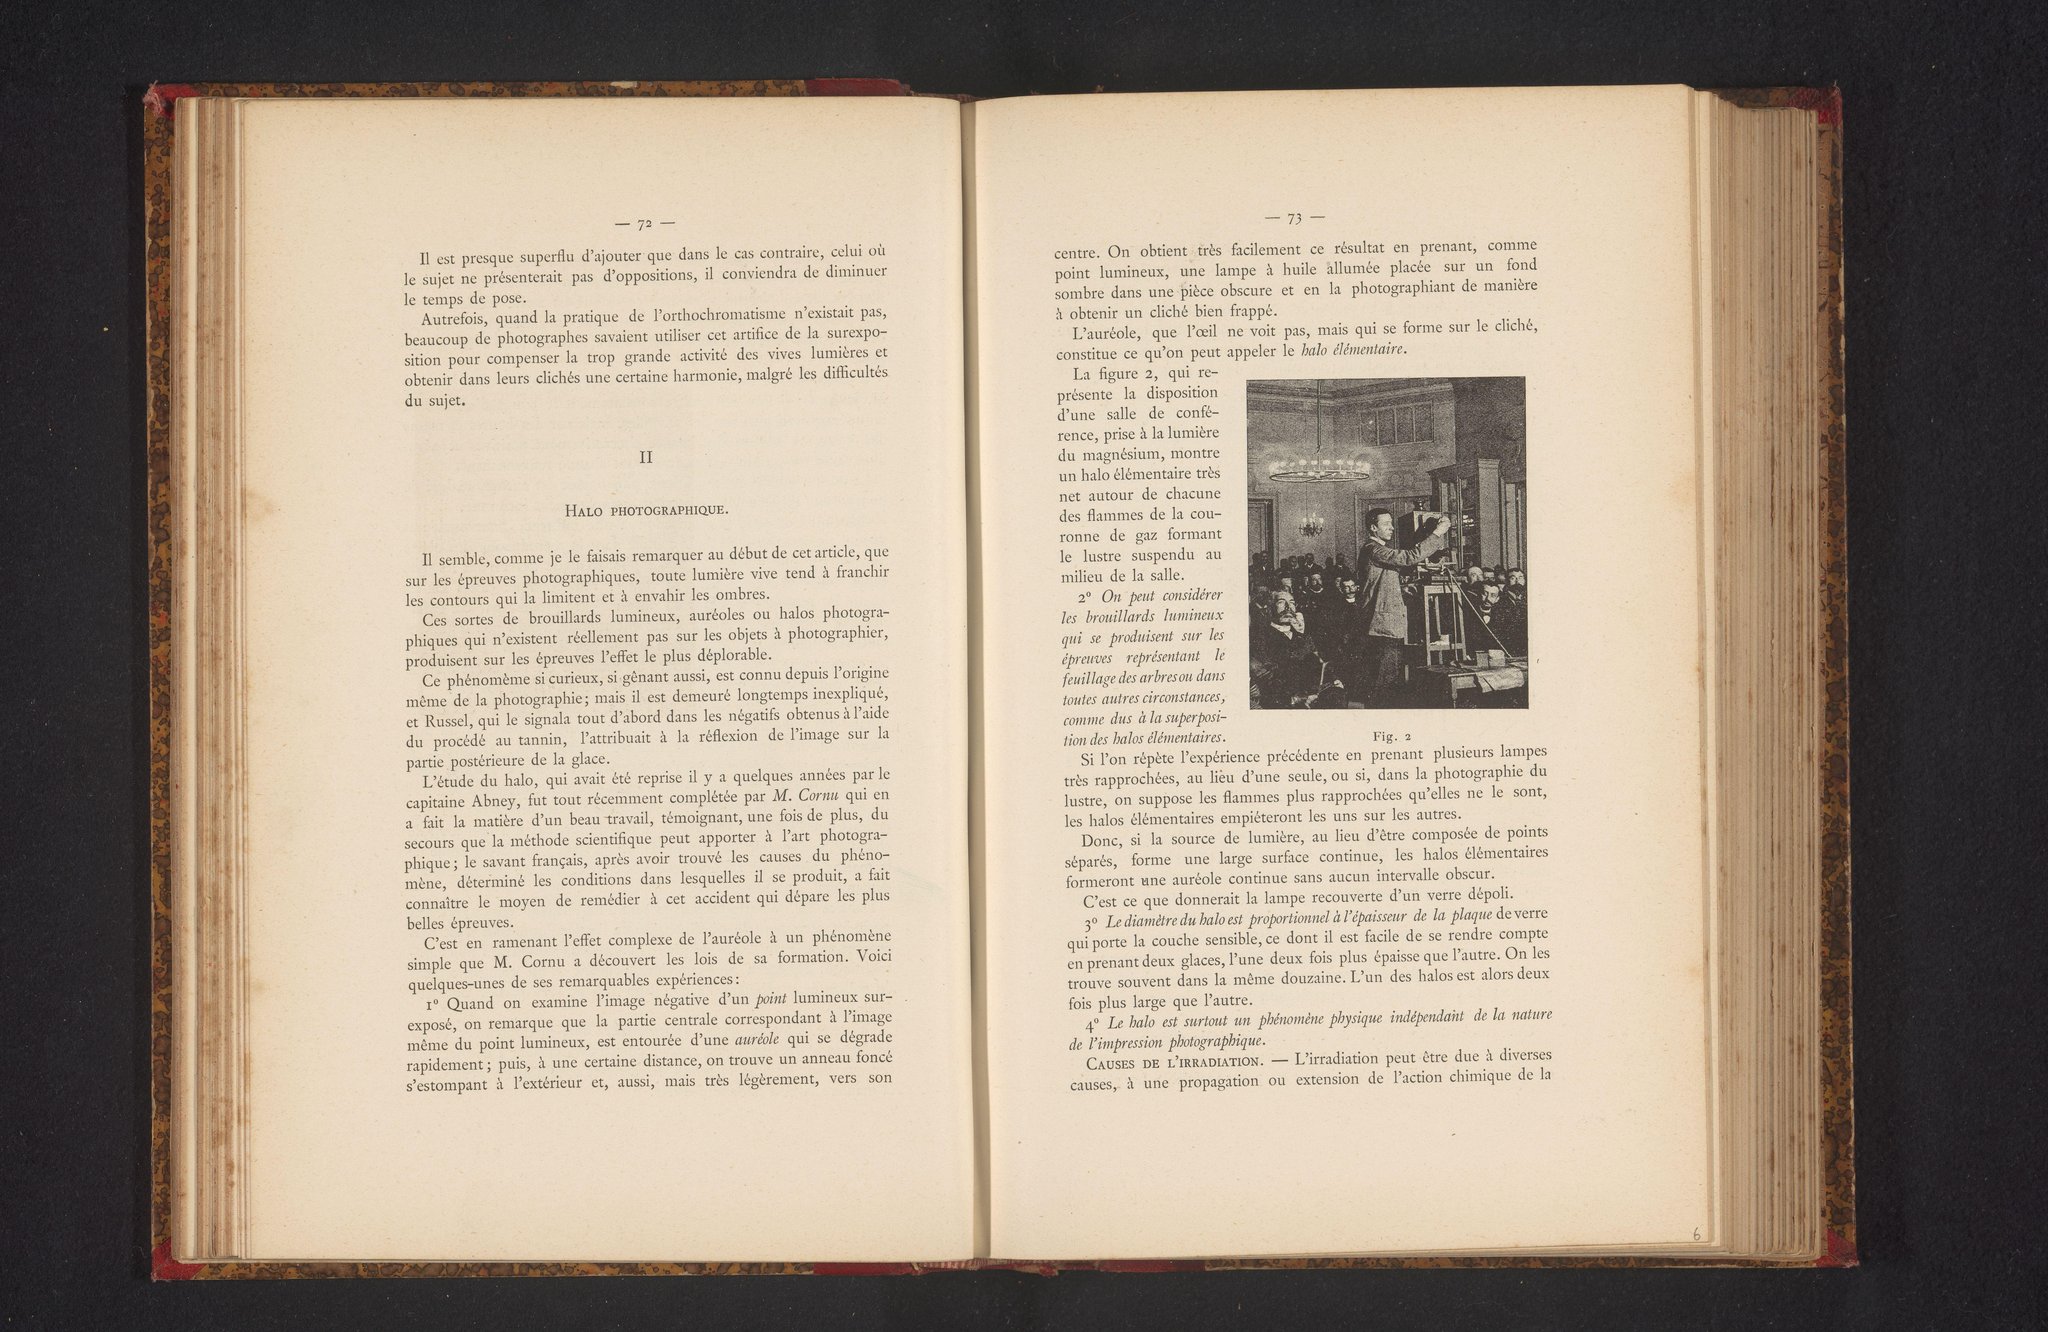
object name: page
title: Groep mannen bekijkt een projectie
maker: Anonymous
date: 1888-1893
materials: paper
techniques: photograph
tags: film projector, adult man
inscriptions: inscription: ‘Fig. 2’